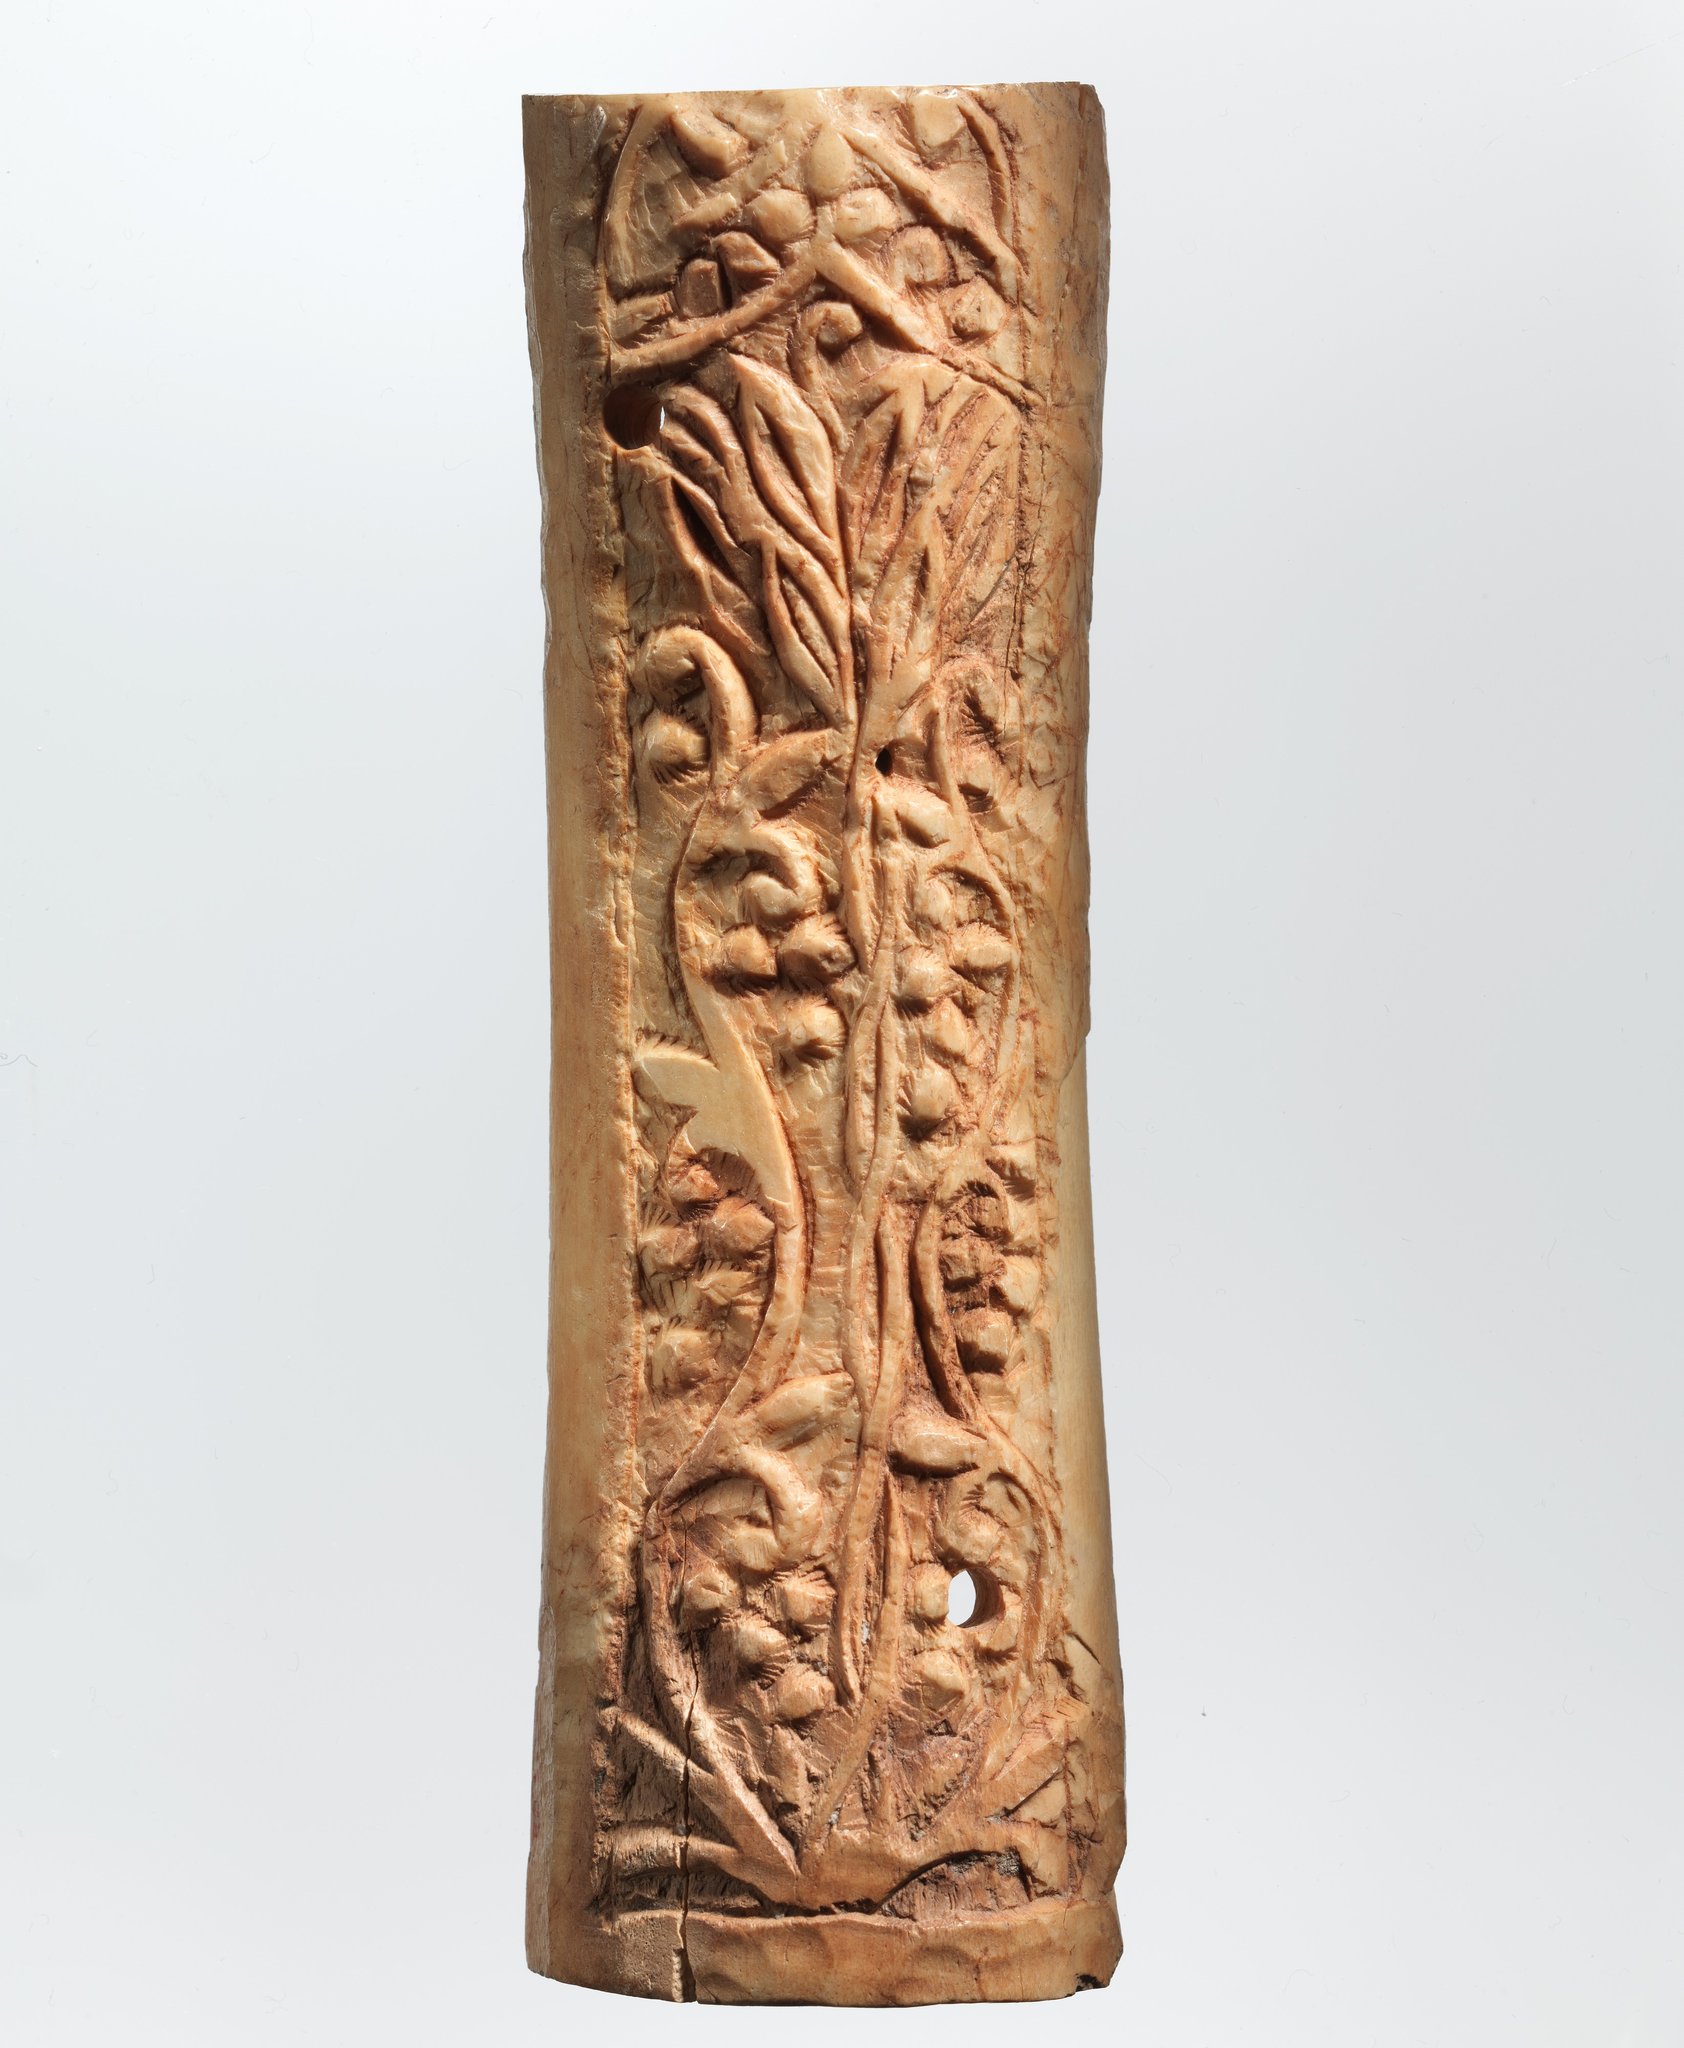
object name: plaque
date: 601-800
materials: bone, paint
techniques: carving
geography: egypt